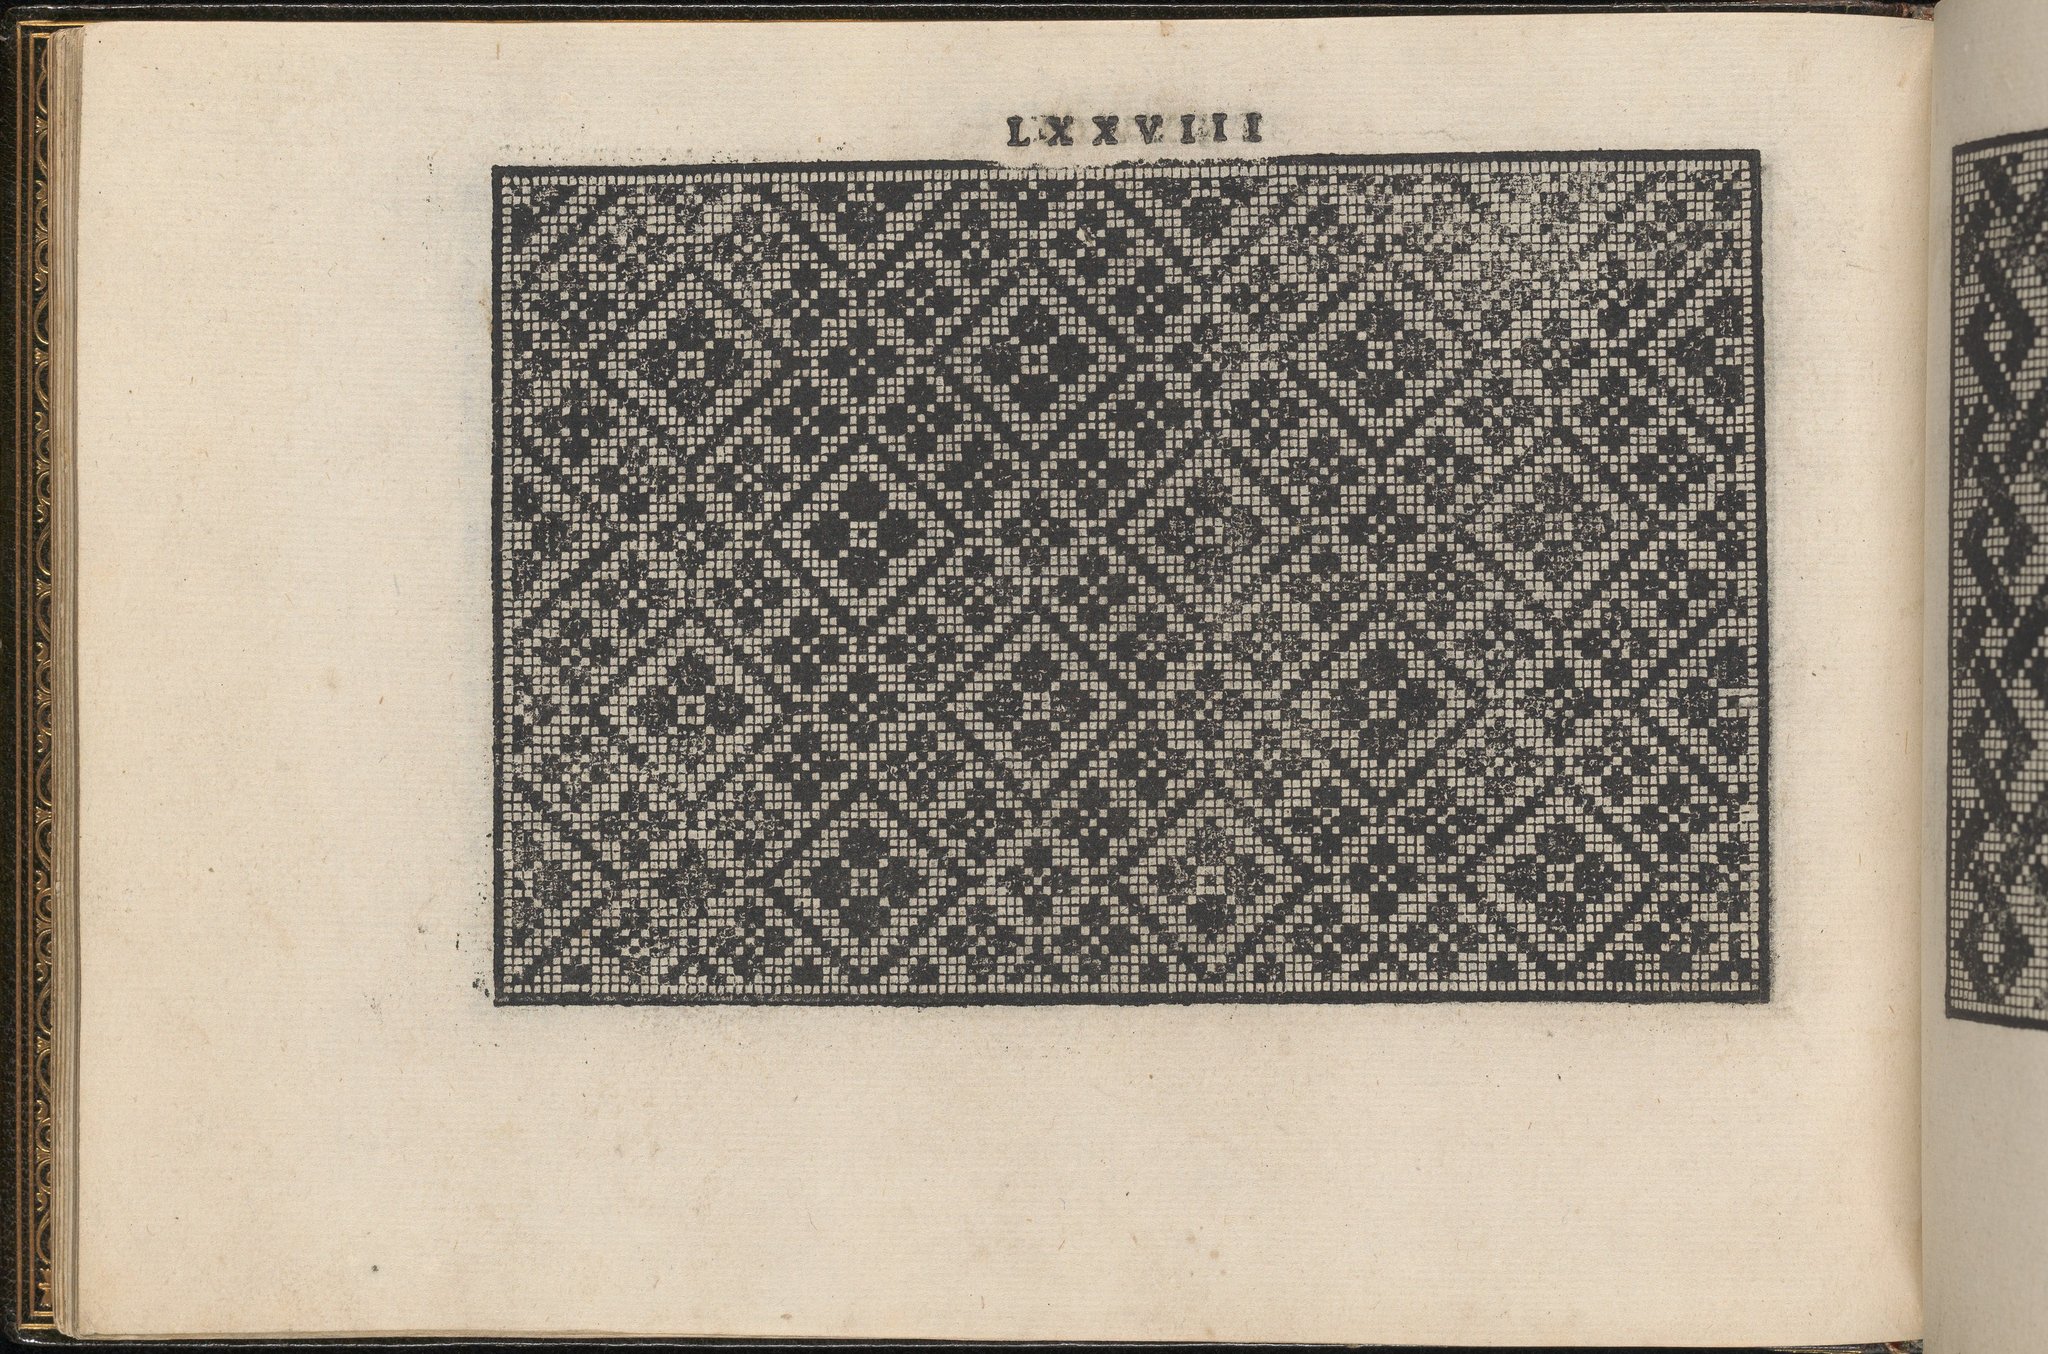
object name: book print ornament architecture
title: La Vera Perfettione del Disegno di varie sorti di recami, page 39 (verso)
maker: giovanni ostaus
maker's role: publisher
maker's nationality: italian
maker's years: 1507-1607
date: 1567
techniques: woodcut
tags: ornament